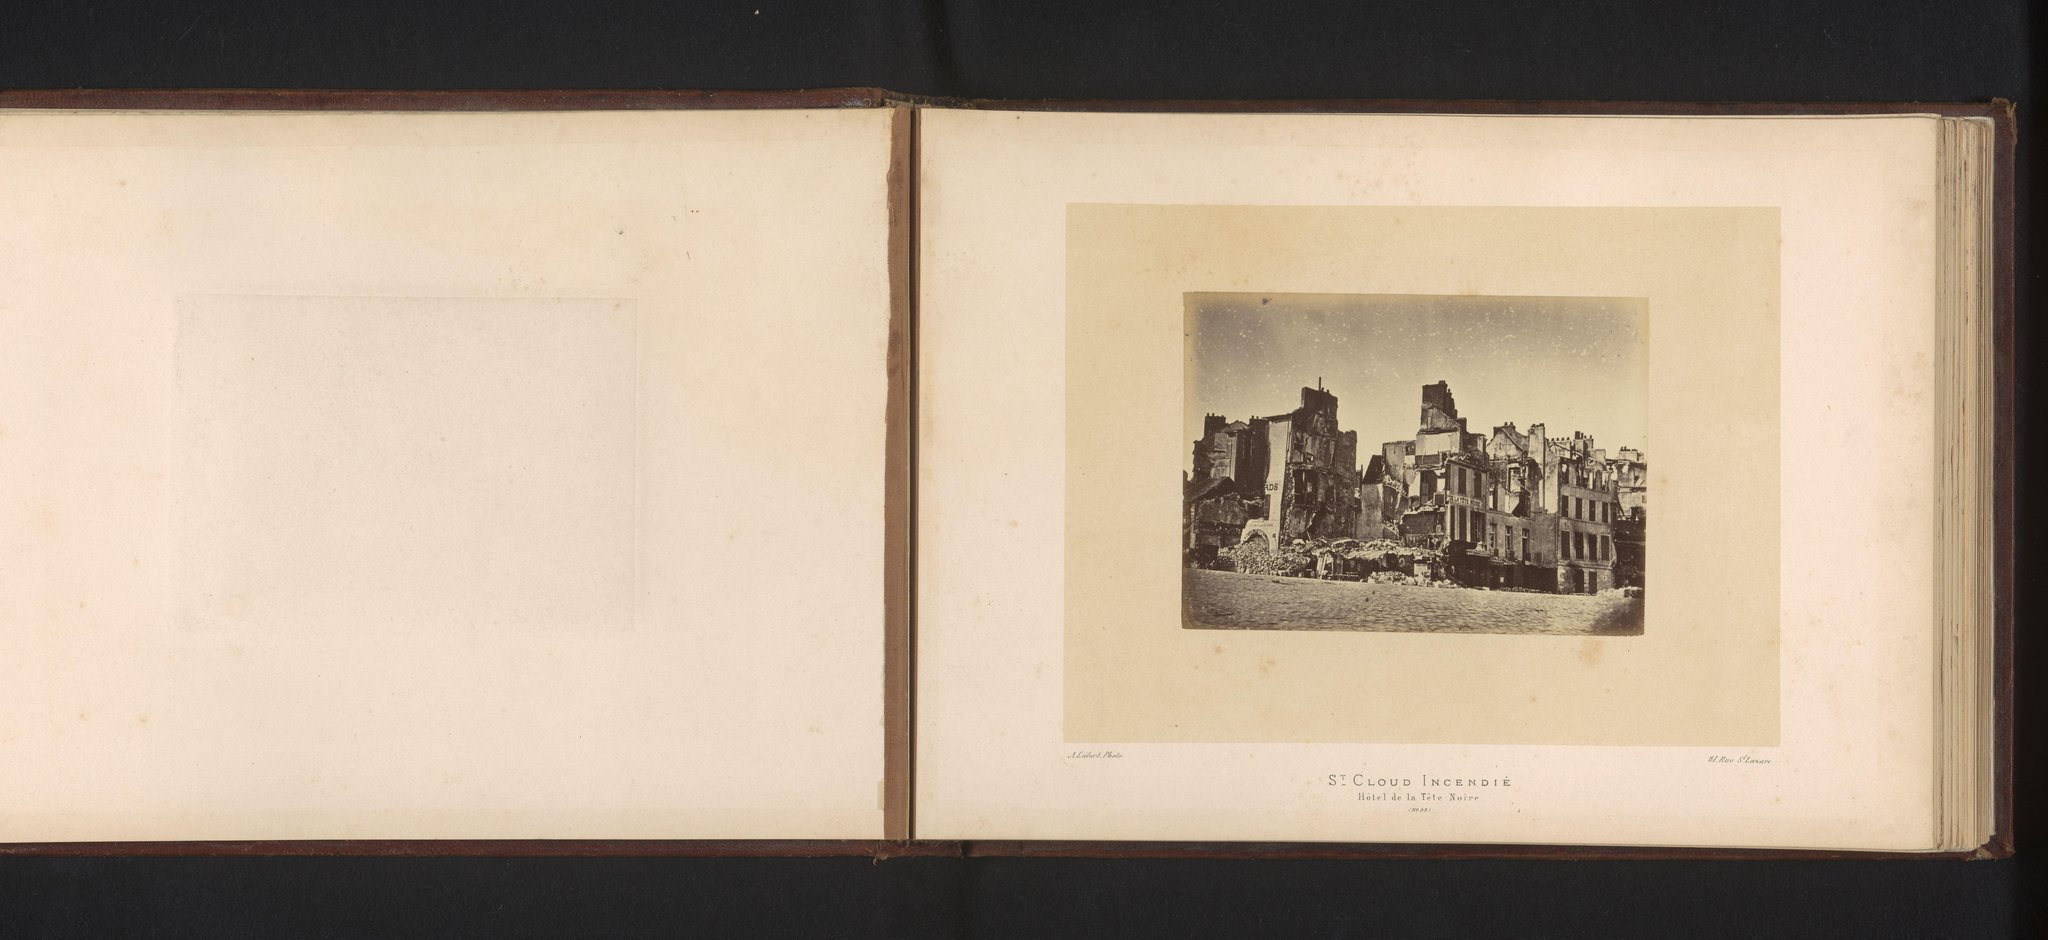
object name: photograph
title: St. Cloud Incendié. Hôtel de la Tête Noire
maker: alphonse-justin liébert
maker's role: fotograaf, marinier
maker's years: 1827-1914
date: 1871-1872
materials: photographic support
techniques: albumen print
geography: saint-cloud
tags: ruin of a building ~ architecture, civic architecture; edifices; dwellings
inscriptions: address: ‘31, Rue St. Lazare’, number: ‘(No. 55)’